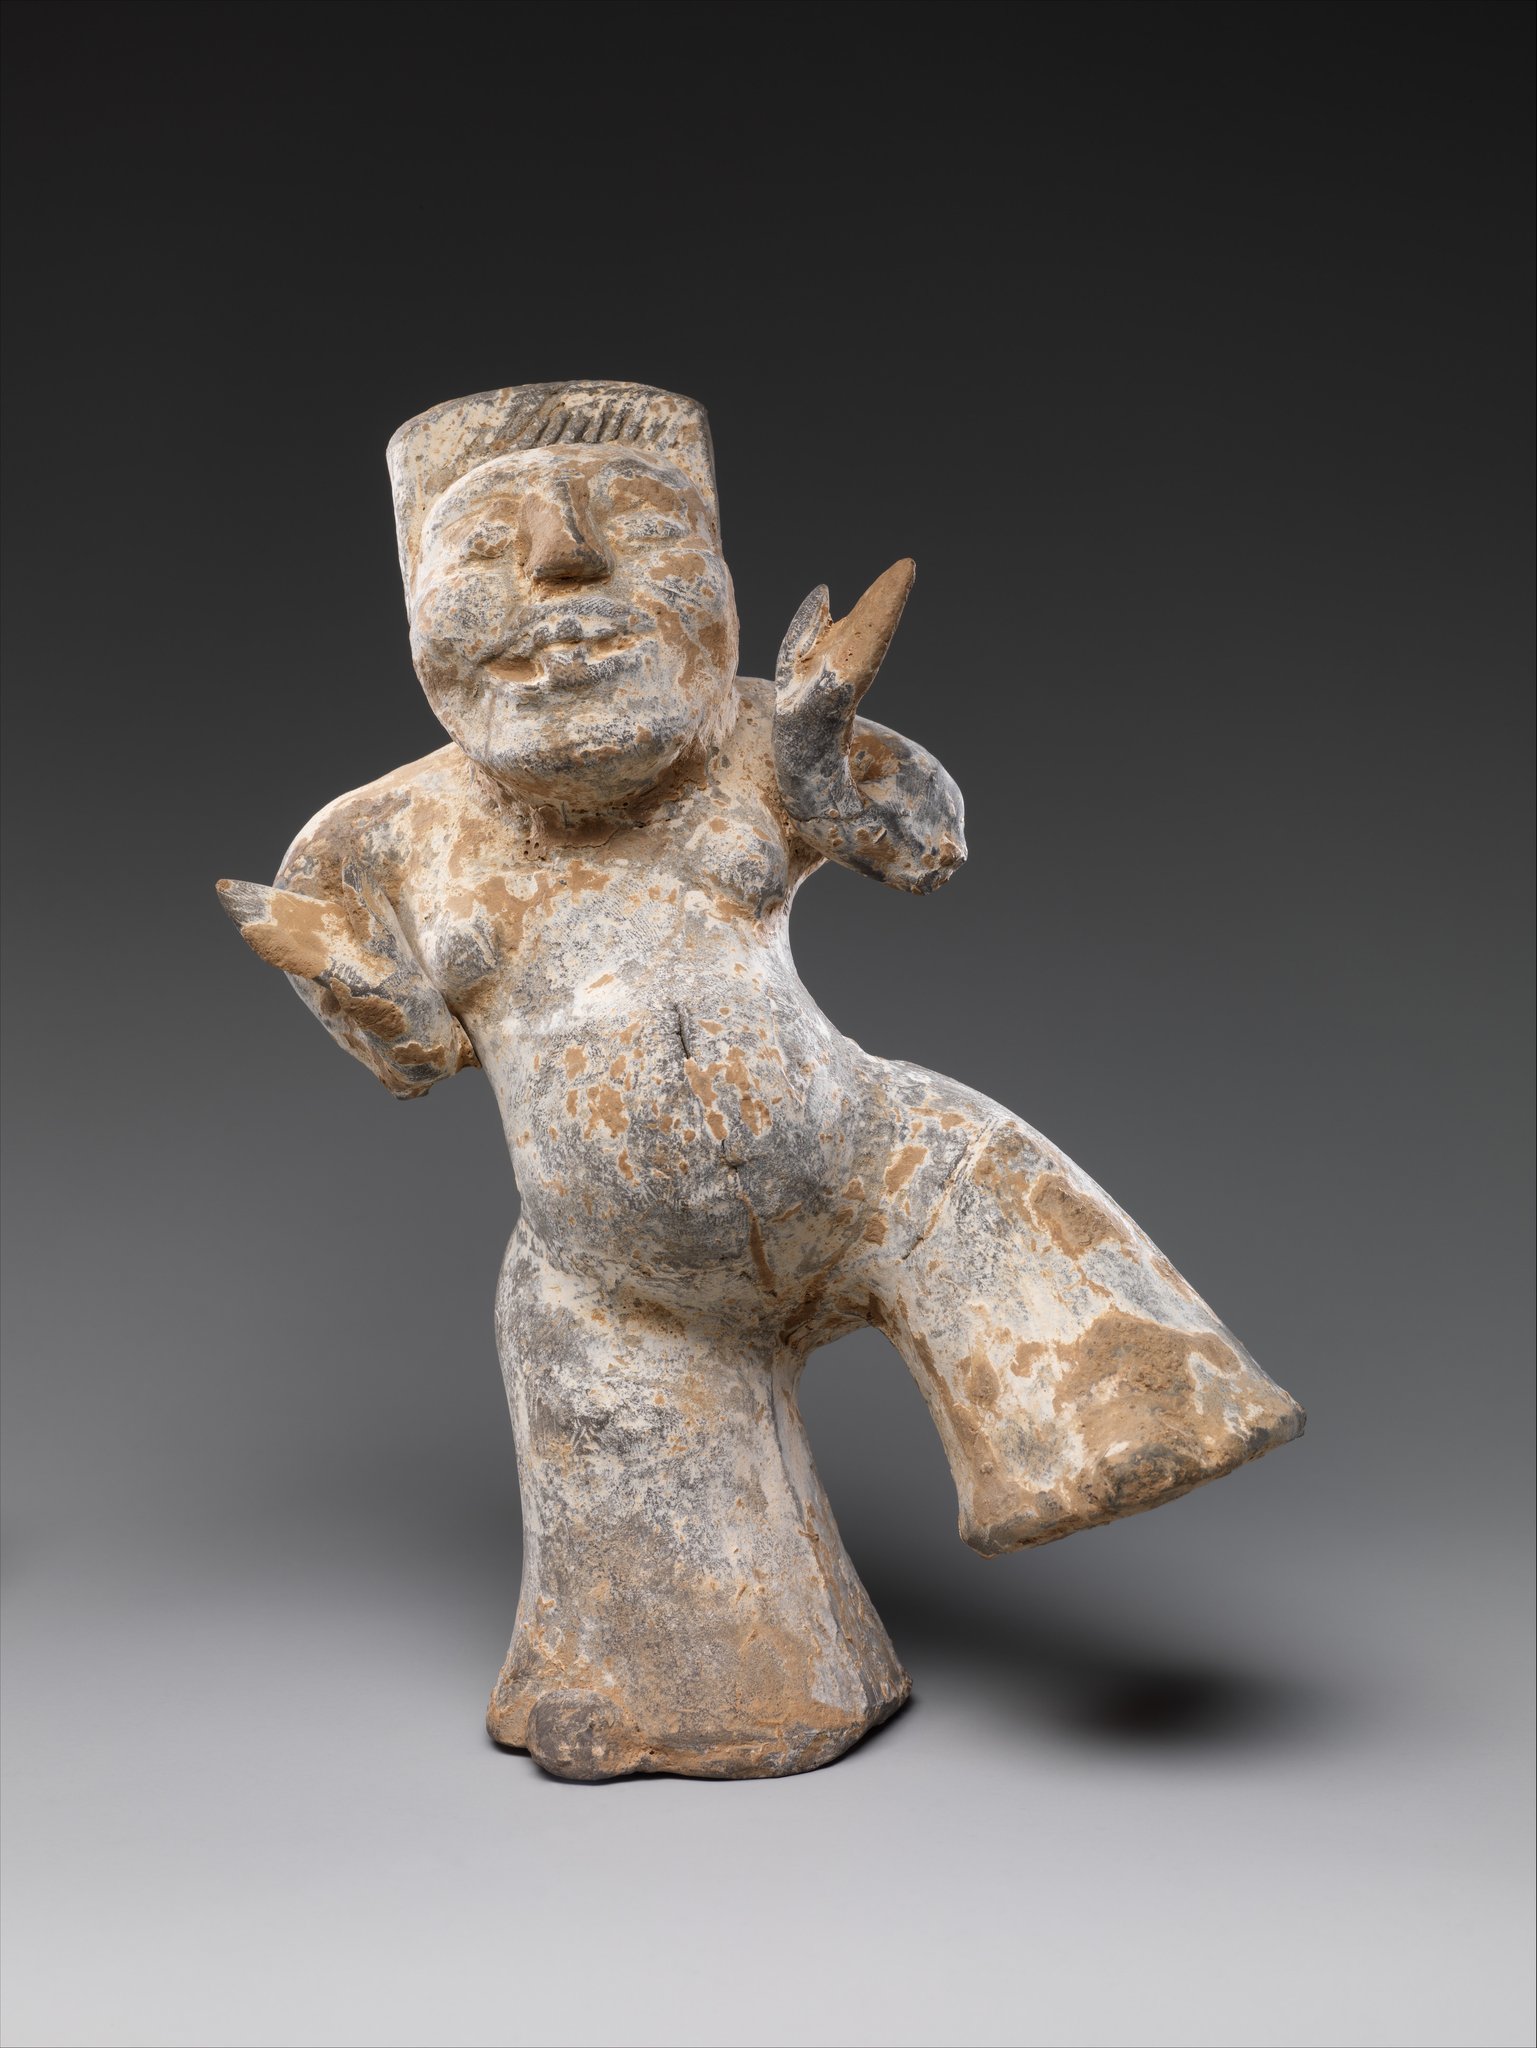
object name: figure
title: Rustic Dancer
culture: chinese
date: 25-220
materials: earthenware, pigment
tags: dancing,dancers